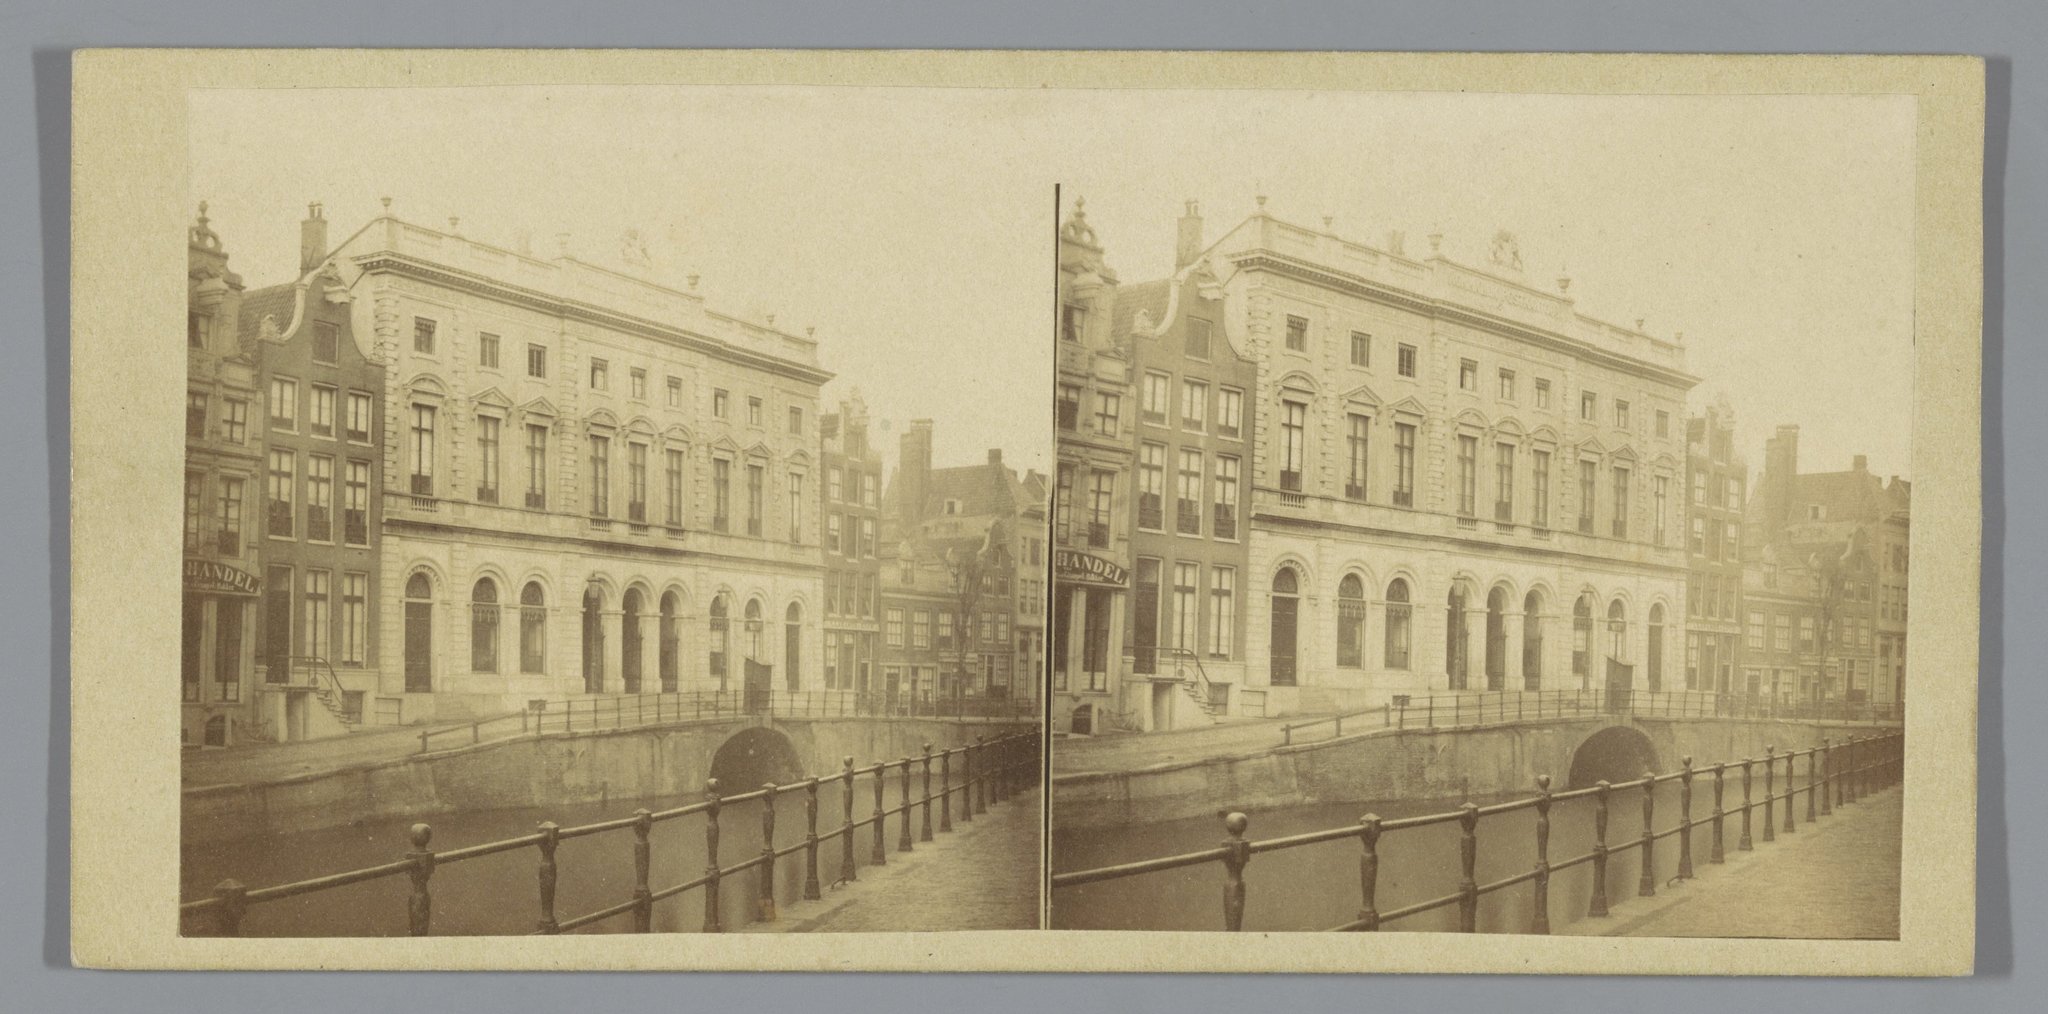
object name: stereograph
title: Koninklijk Postkantoor aan de Nieuwezijds Voorburgwal, Amsterdam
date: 1859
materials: cardboard, paper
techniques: albumen print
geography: amsterdam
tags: post-office, canals, waters (in city)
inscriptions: inscription: ‘Gebouwd gedurende de jaren 1854, 1855 en 1856, en voltooid in 1857./ Gephotographiëerd in Februarij 1859./ Uitgegeven door A. Jager, Water 110, te Amsterdam.’, number: ‘No. 12.’